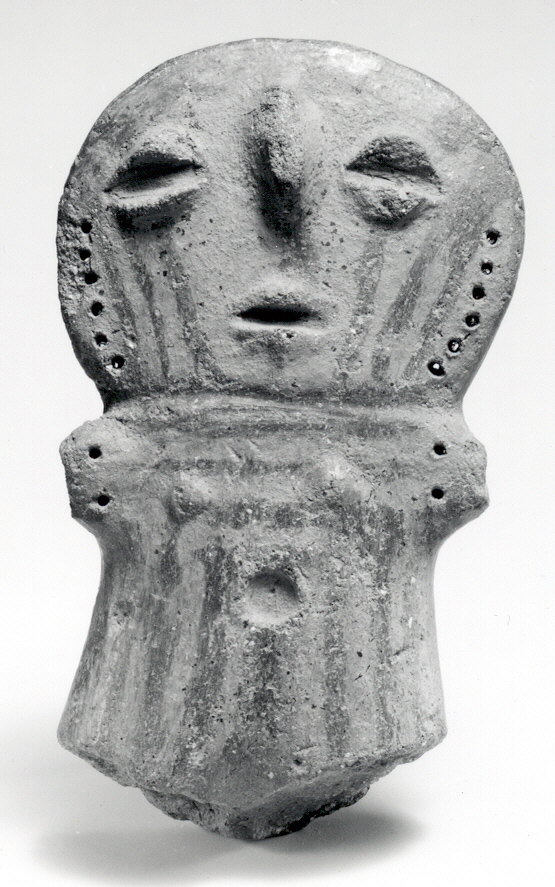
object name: figure fragment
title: Ceramic Female Fragment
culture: machalilla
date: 2000-1 BCE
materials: ceramic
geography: ecuador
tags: women